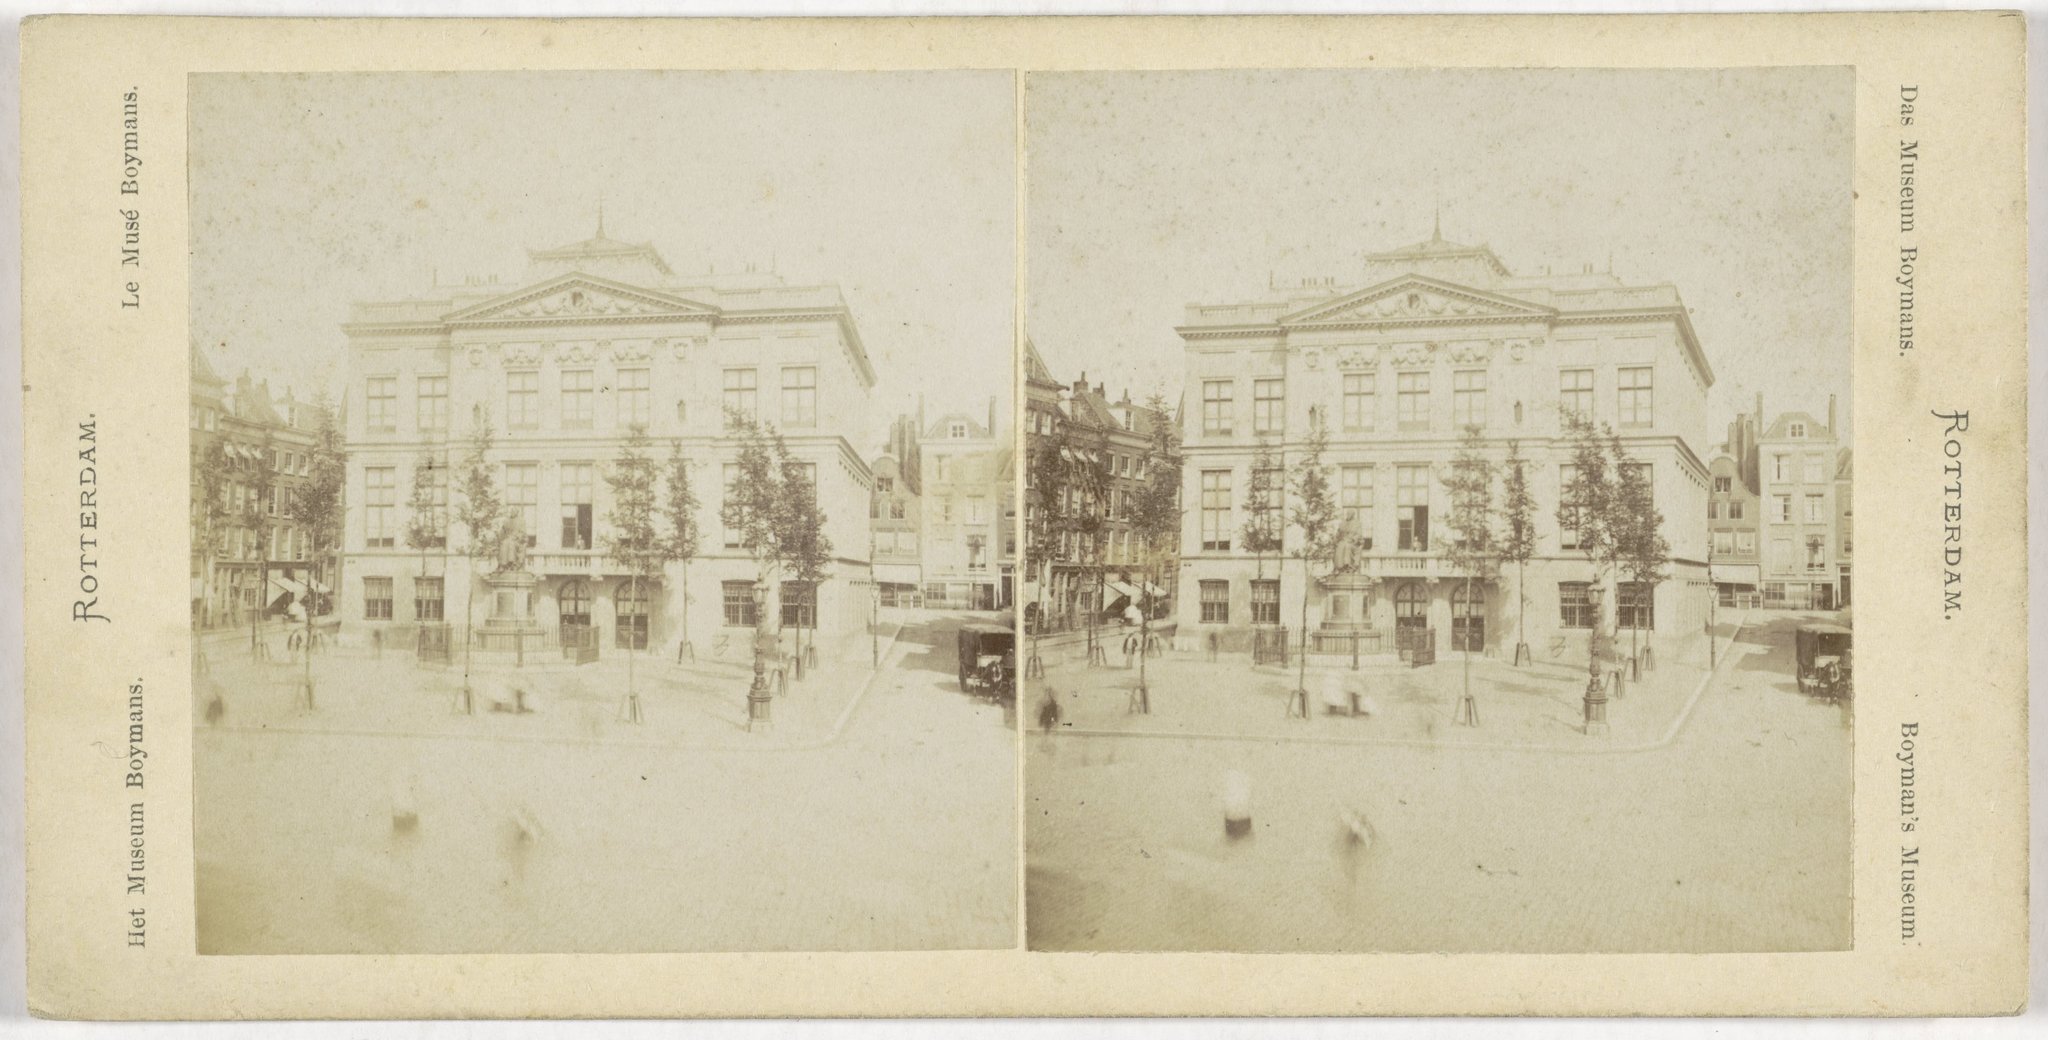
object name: stereograph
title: Gezicht op het Schielandshuis in Rotterdam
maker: Anonymous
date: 1867-1870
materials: cardboard, paper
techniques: albumen print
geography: rotterdam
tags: villa